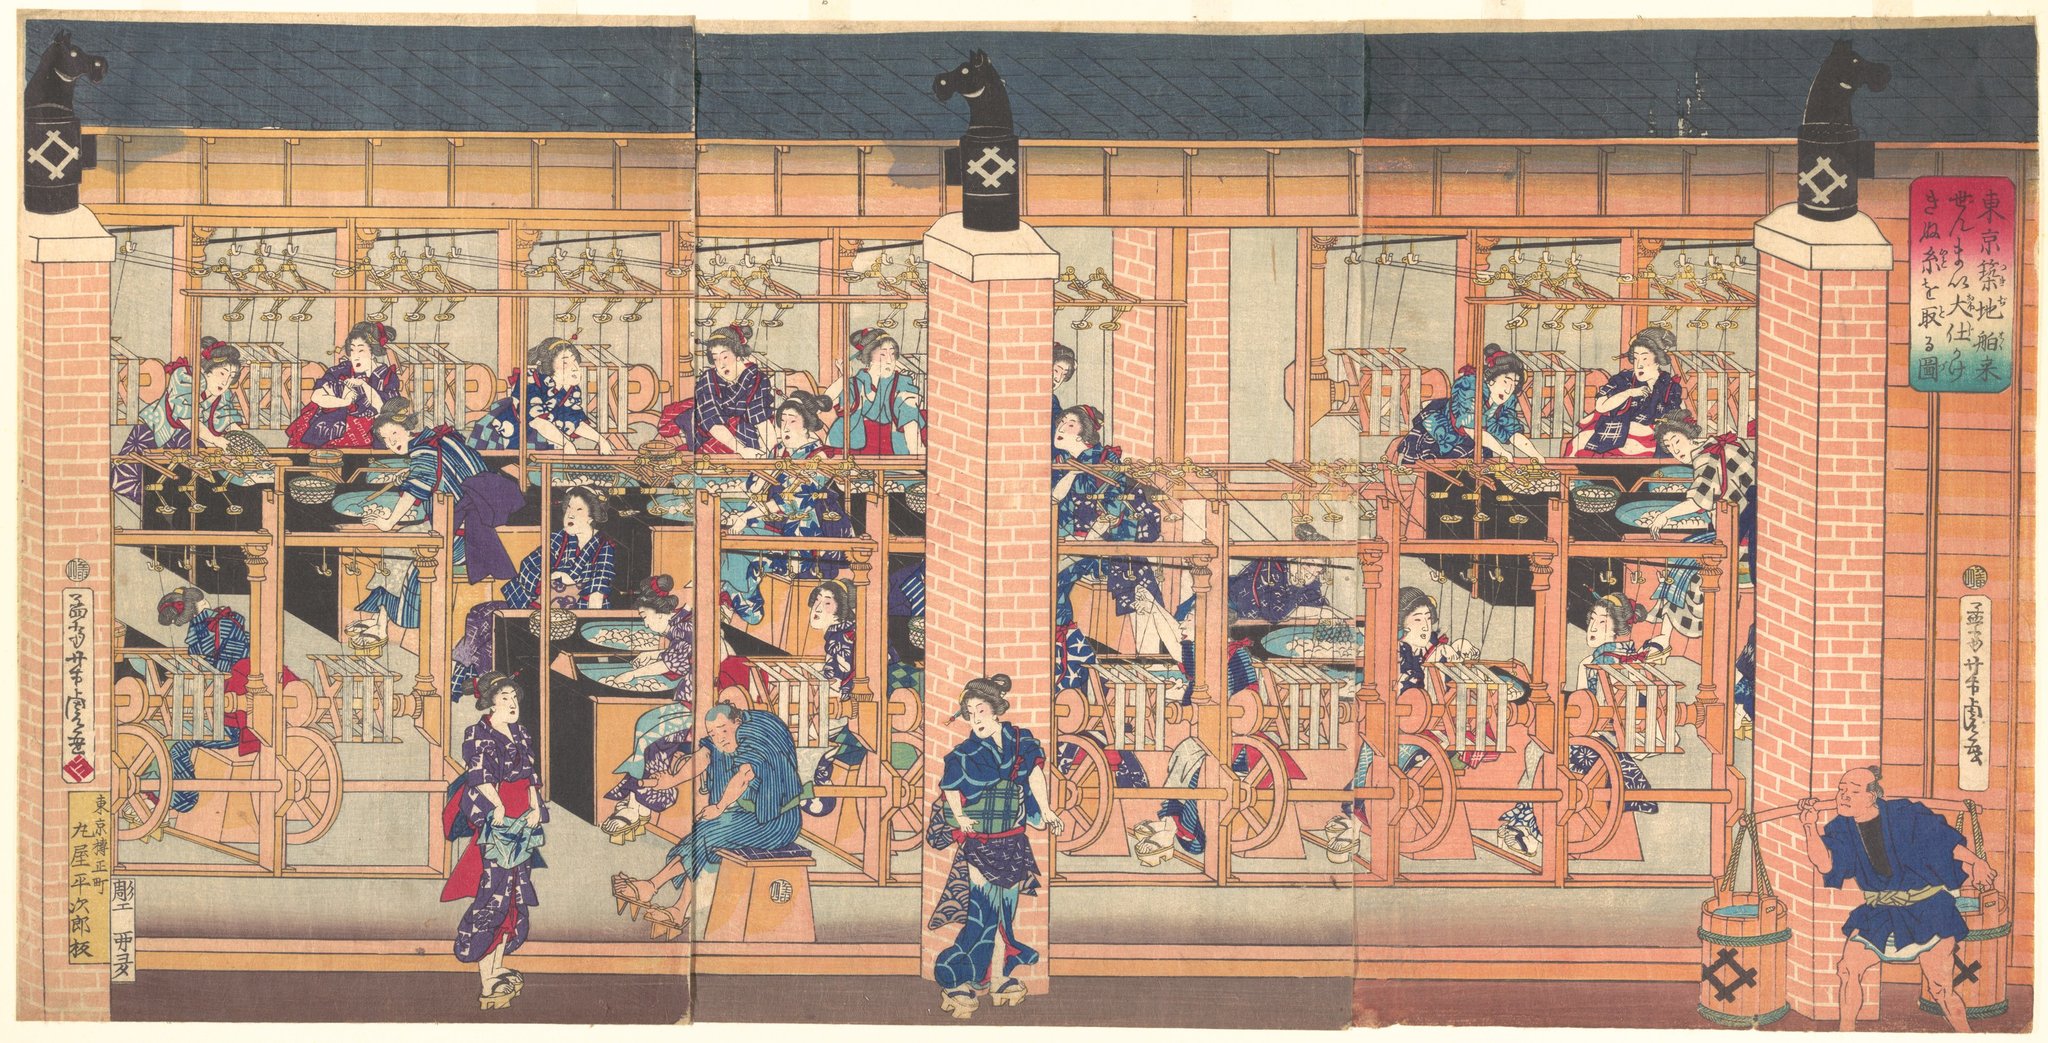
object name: print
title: Imported Silk Reeling Machine at Tsukiji in Tokyo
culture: japanese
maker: utagawa yoshitora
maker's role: artist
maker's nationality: japanese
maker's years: 1845-1880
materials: ink, paper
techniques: woodblock print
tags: men,women,working,industry,machines